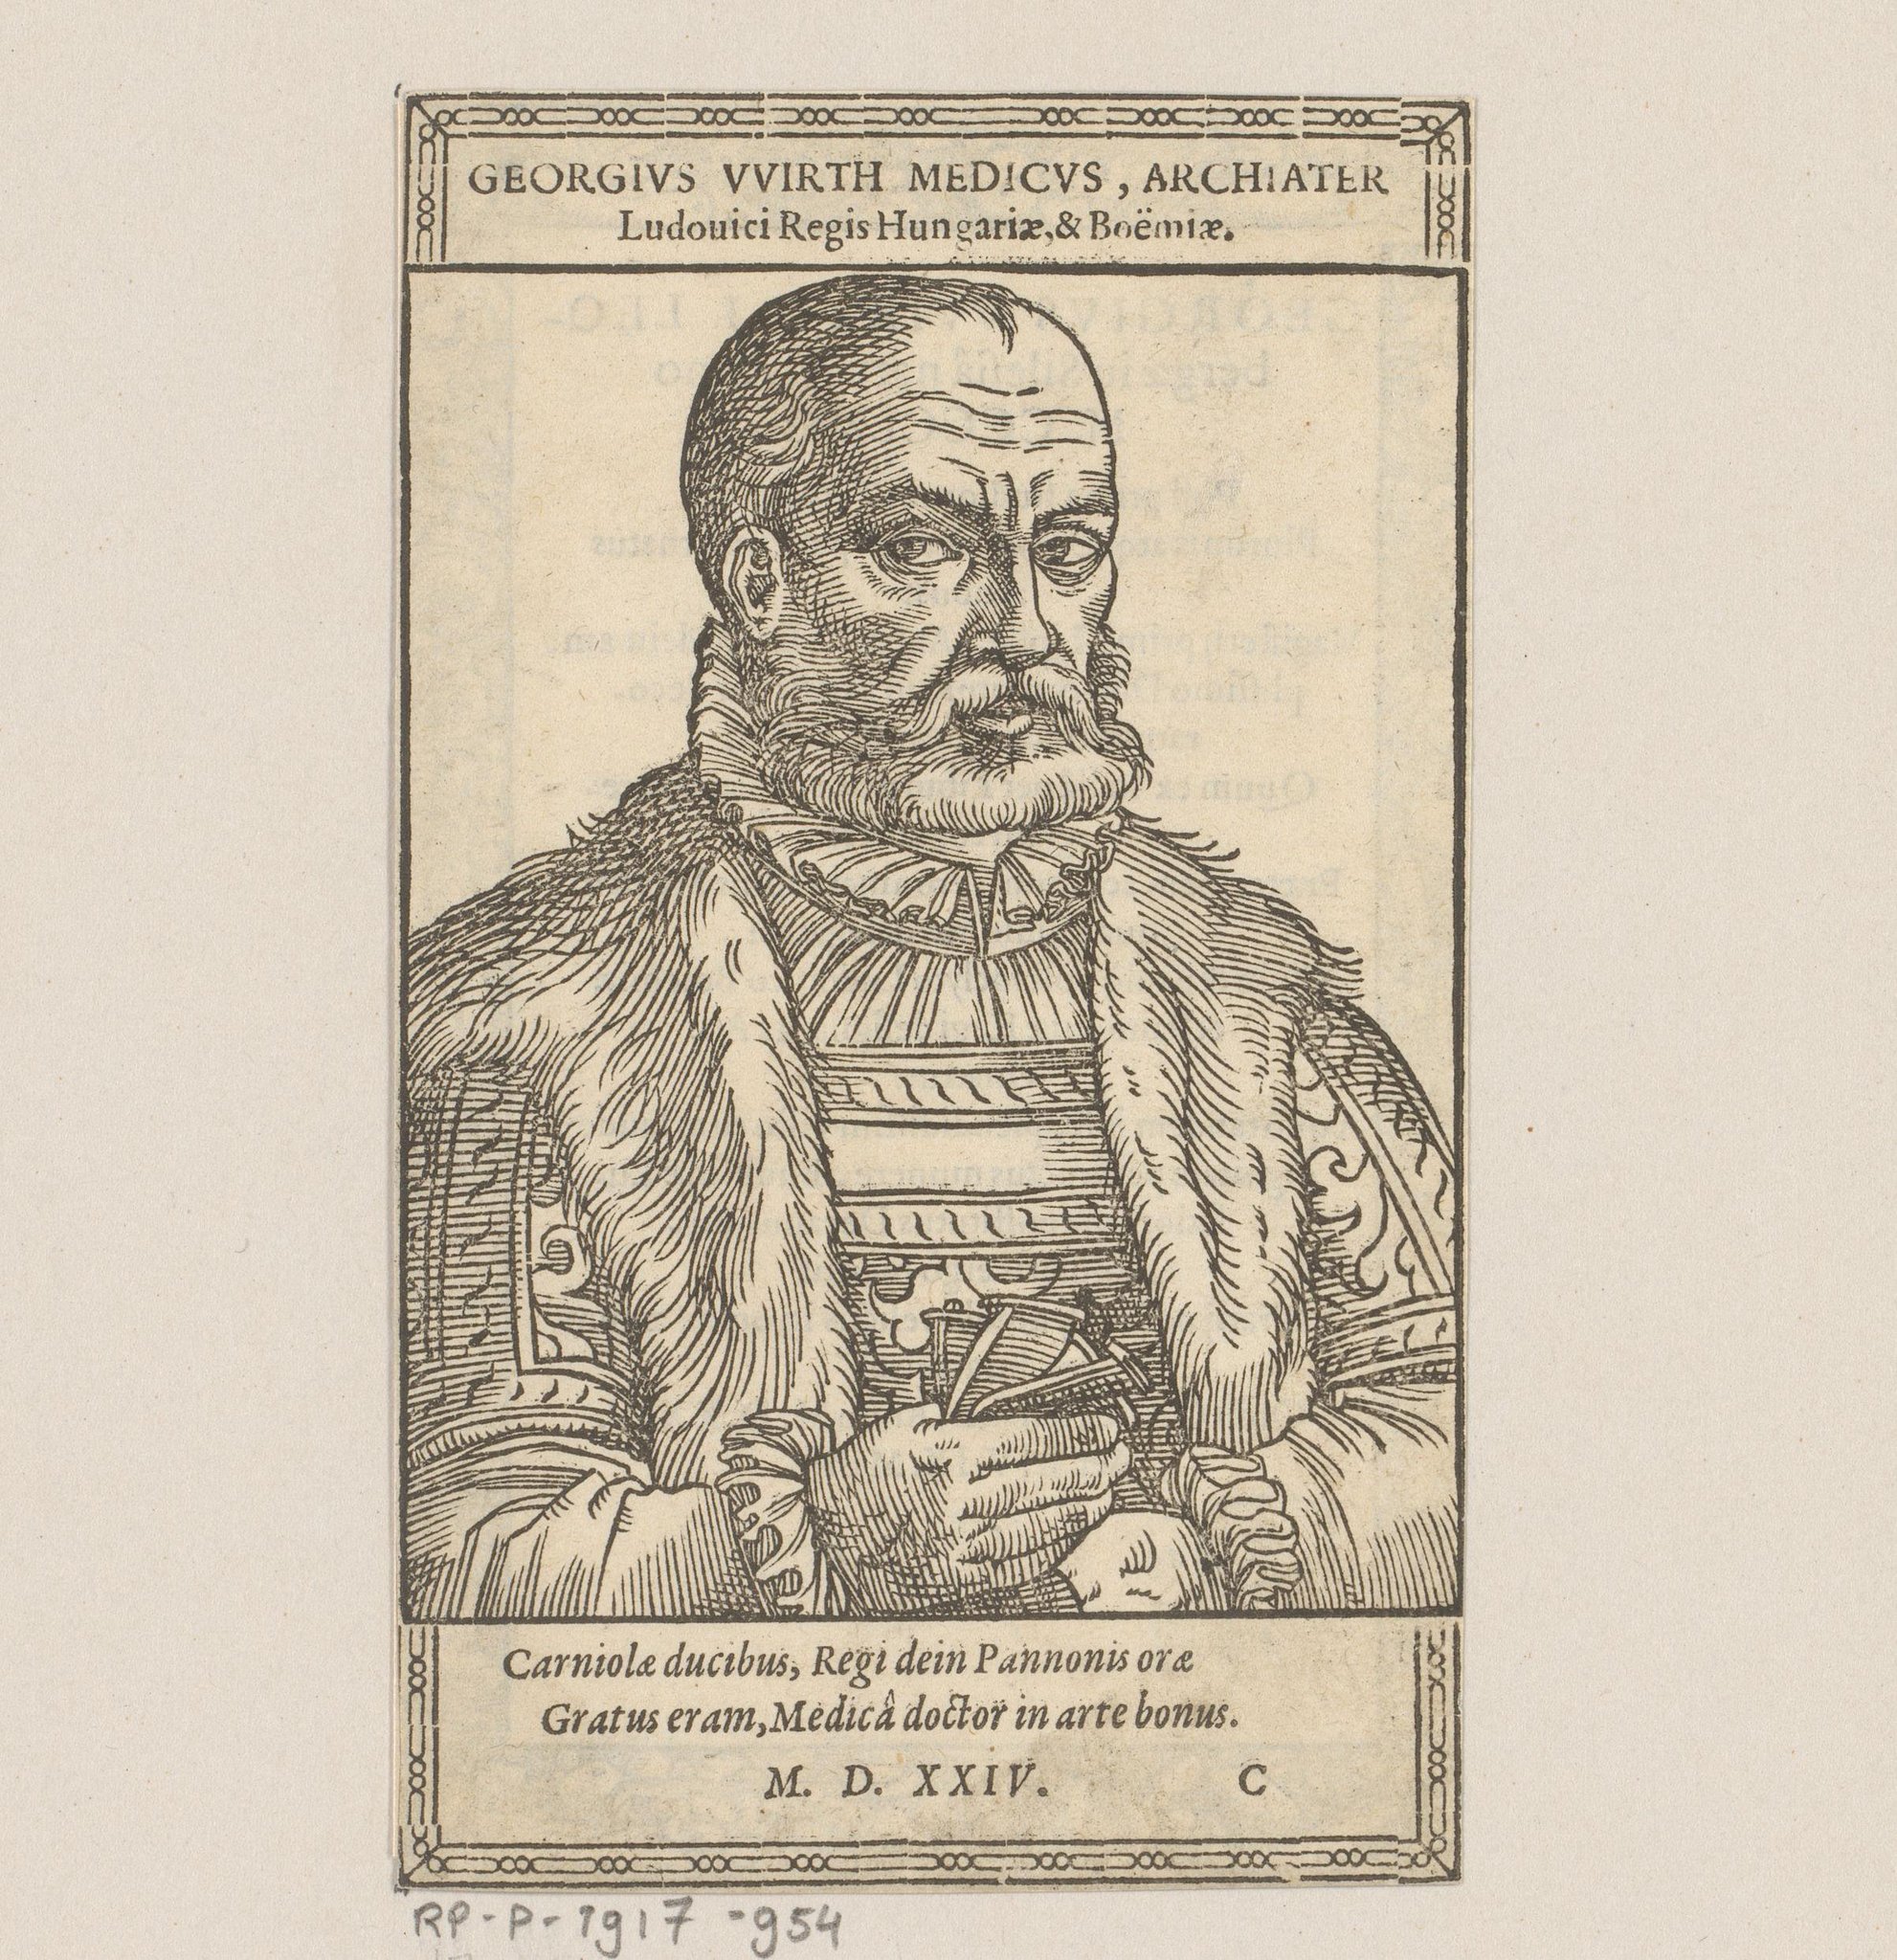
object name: print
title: Portret van Georg Wirth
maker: bernhard jobin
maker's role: printer, publisher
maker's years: 1545-1593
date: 1587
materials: paper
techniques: letterpress printing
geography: straatsburg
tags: historical persons, physician, doctor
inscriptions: collector's mark: Lugt 2228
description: Prent uit: Reusner, Nikolaus. Icones sive imagines virorum literis illustrium (...). Straatsburg: Bernhard Jobin, 1587. Prent ook gebruikt in de Duitse editie, uitgegeven in hetzelfde jaar, en de 1590-editie. Prent ook gebruikt in latere publicaties.